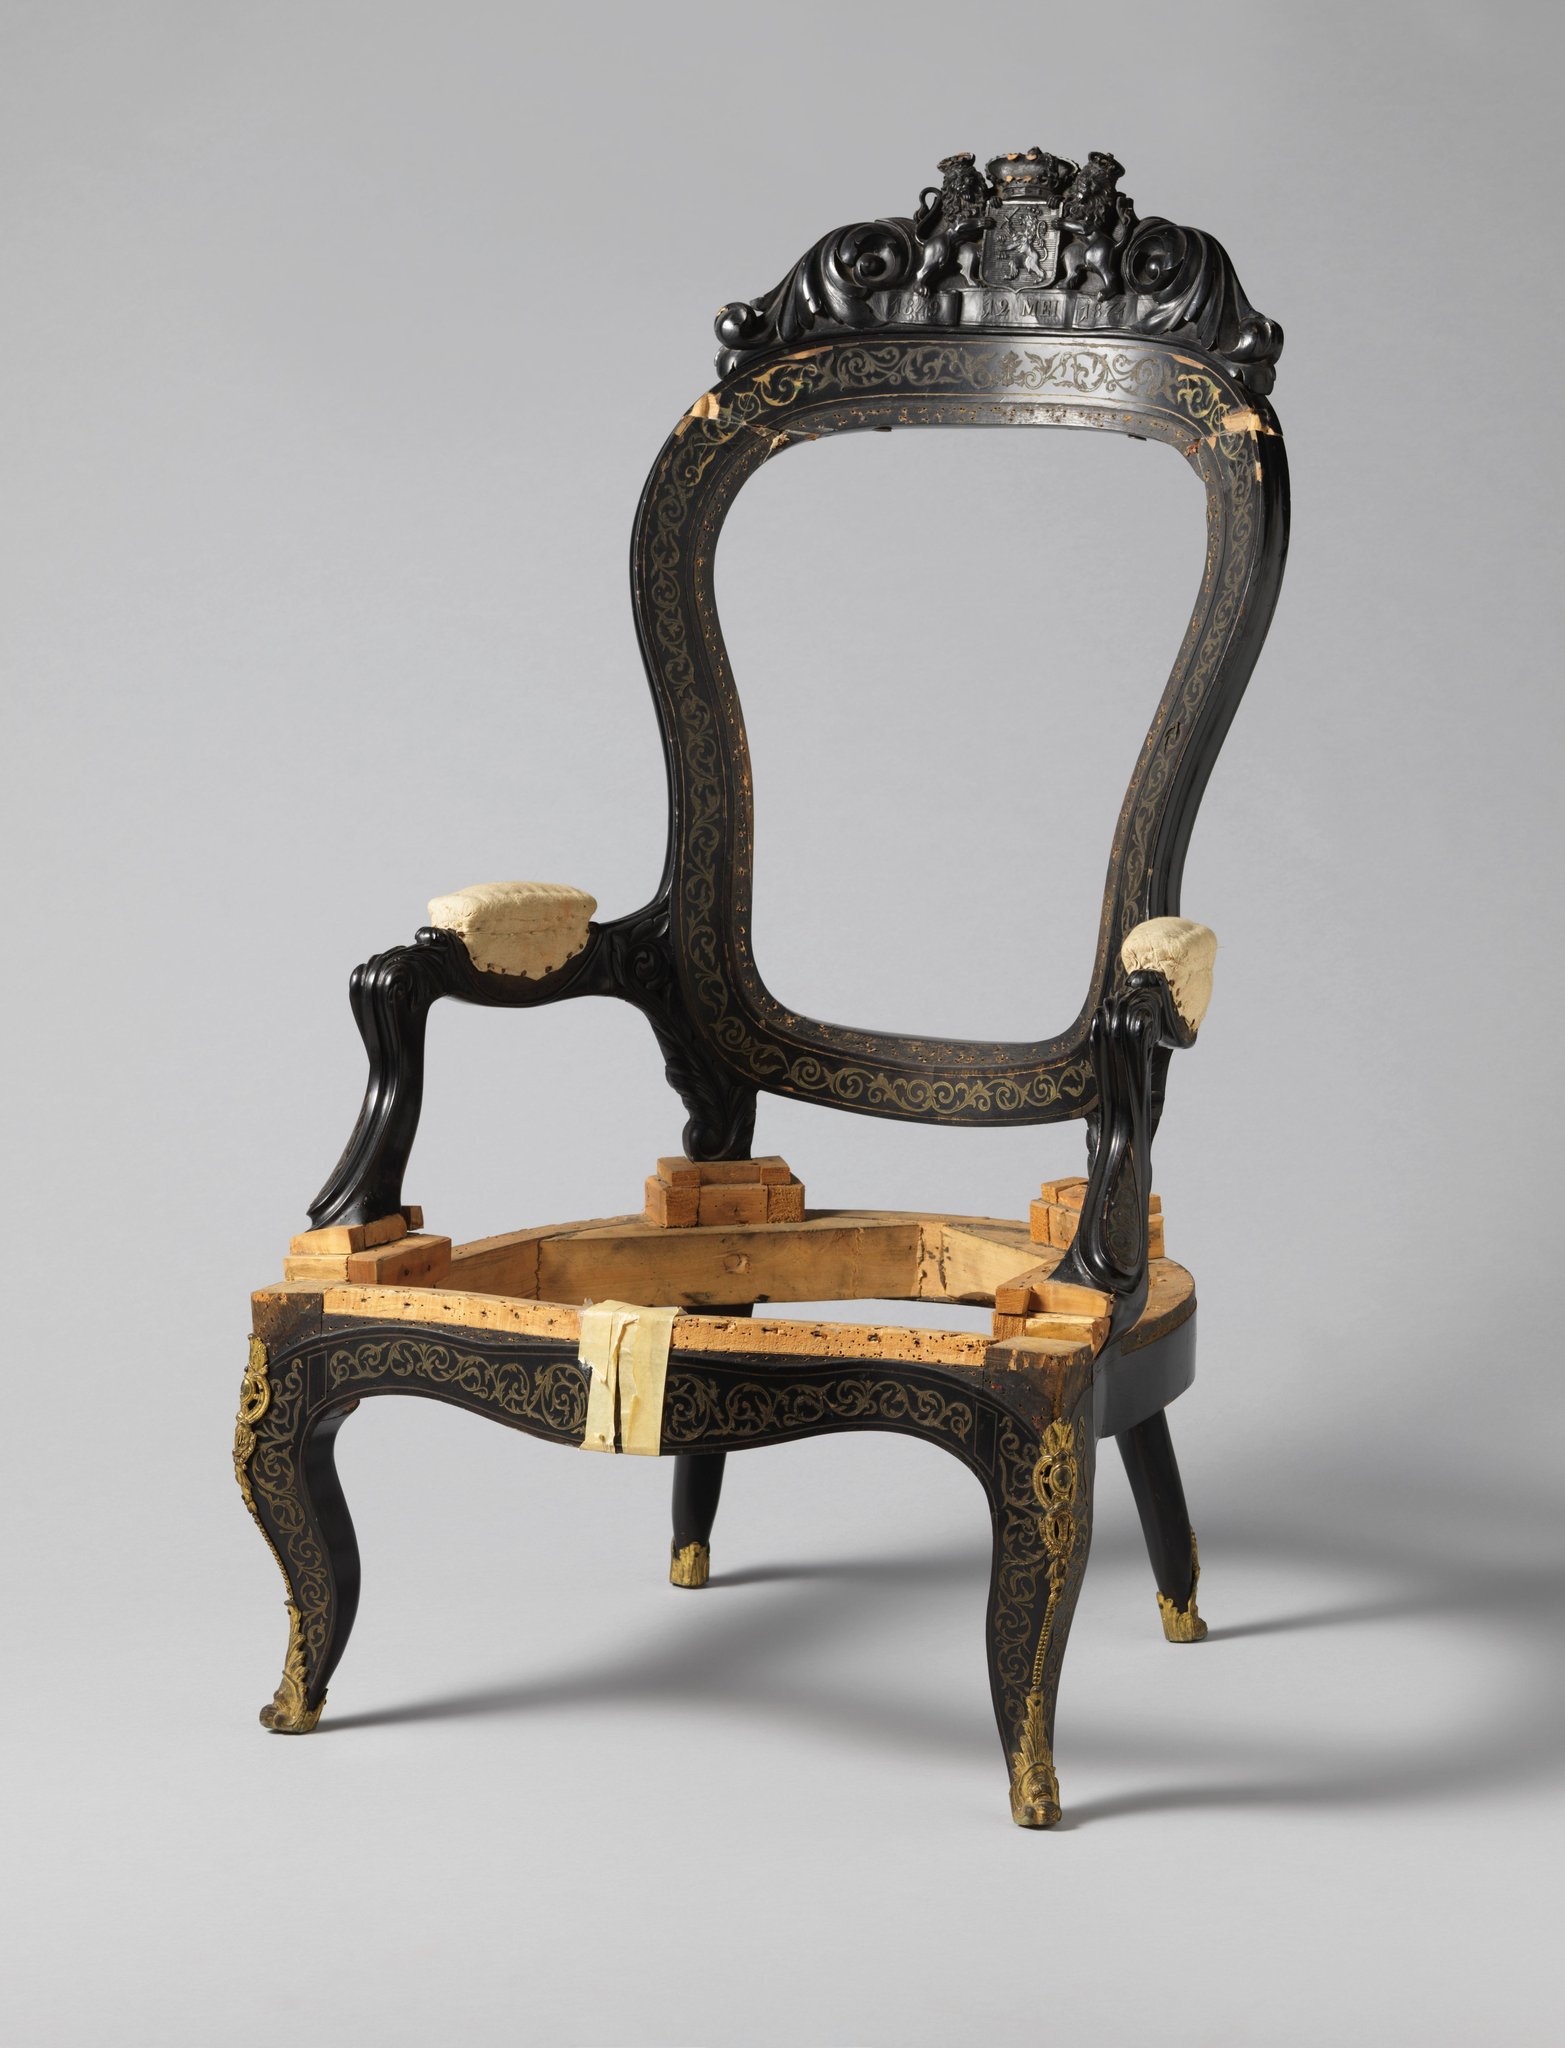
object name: armchair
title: Voltaire armstoel met zwarte Boulle maqueterie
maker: Anonymous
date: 1874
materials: wood, brass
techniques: gilding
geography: netherlands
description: Voltaire armstoel met zwarte Boulle maqueterie. Op de stoel een merk: 1849 12 mei 1874. De stoffering van de stoel ontbreekt.